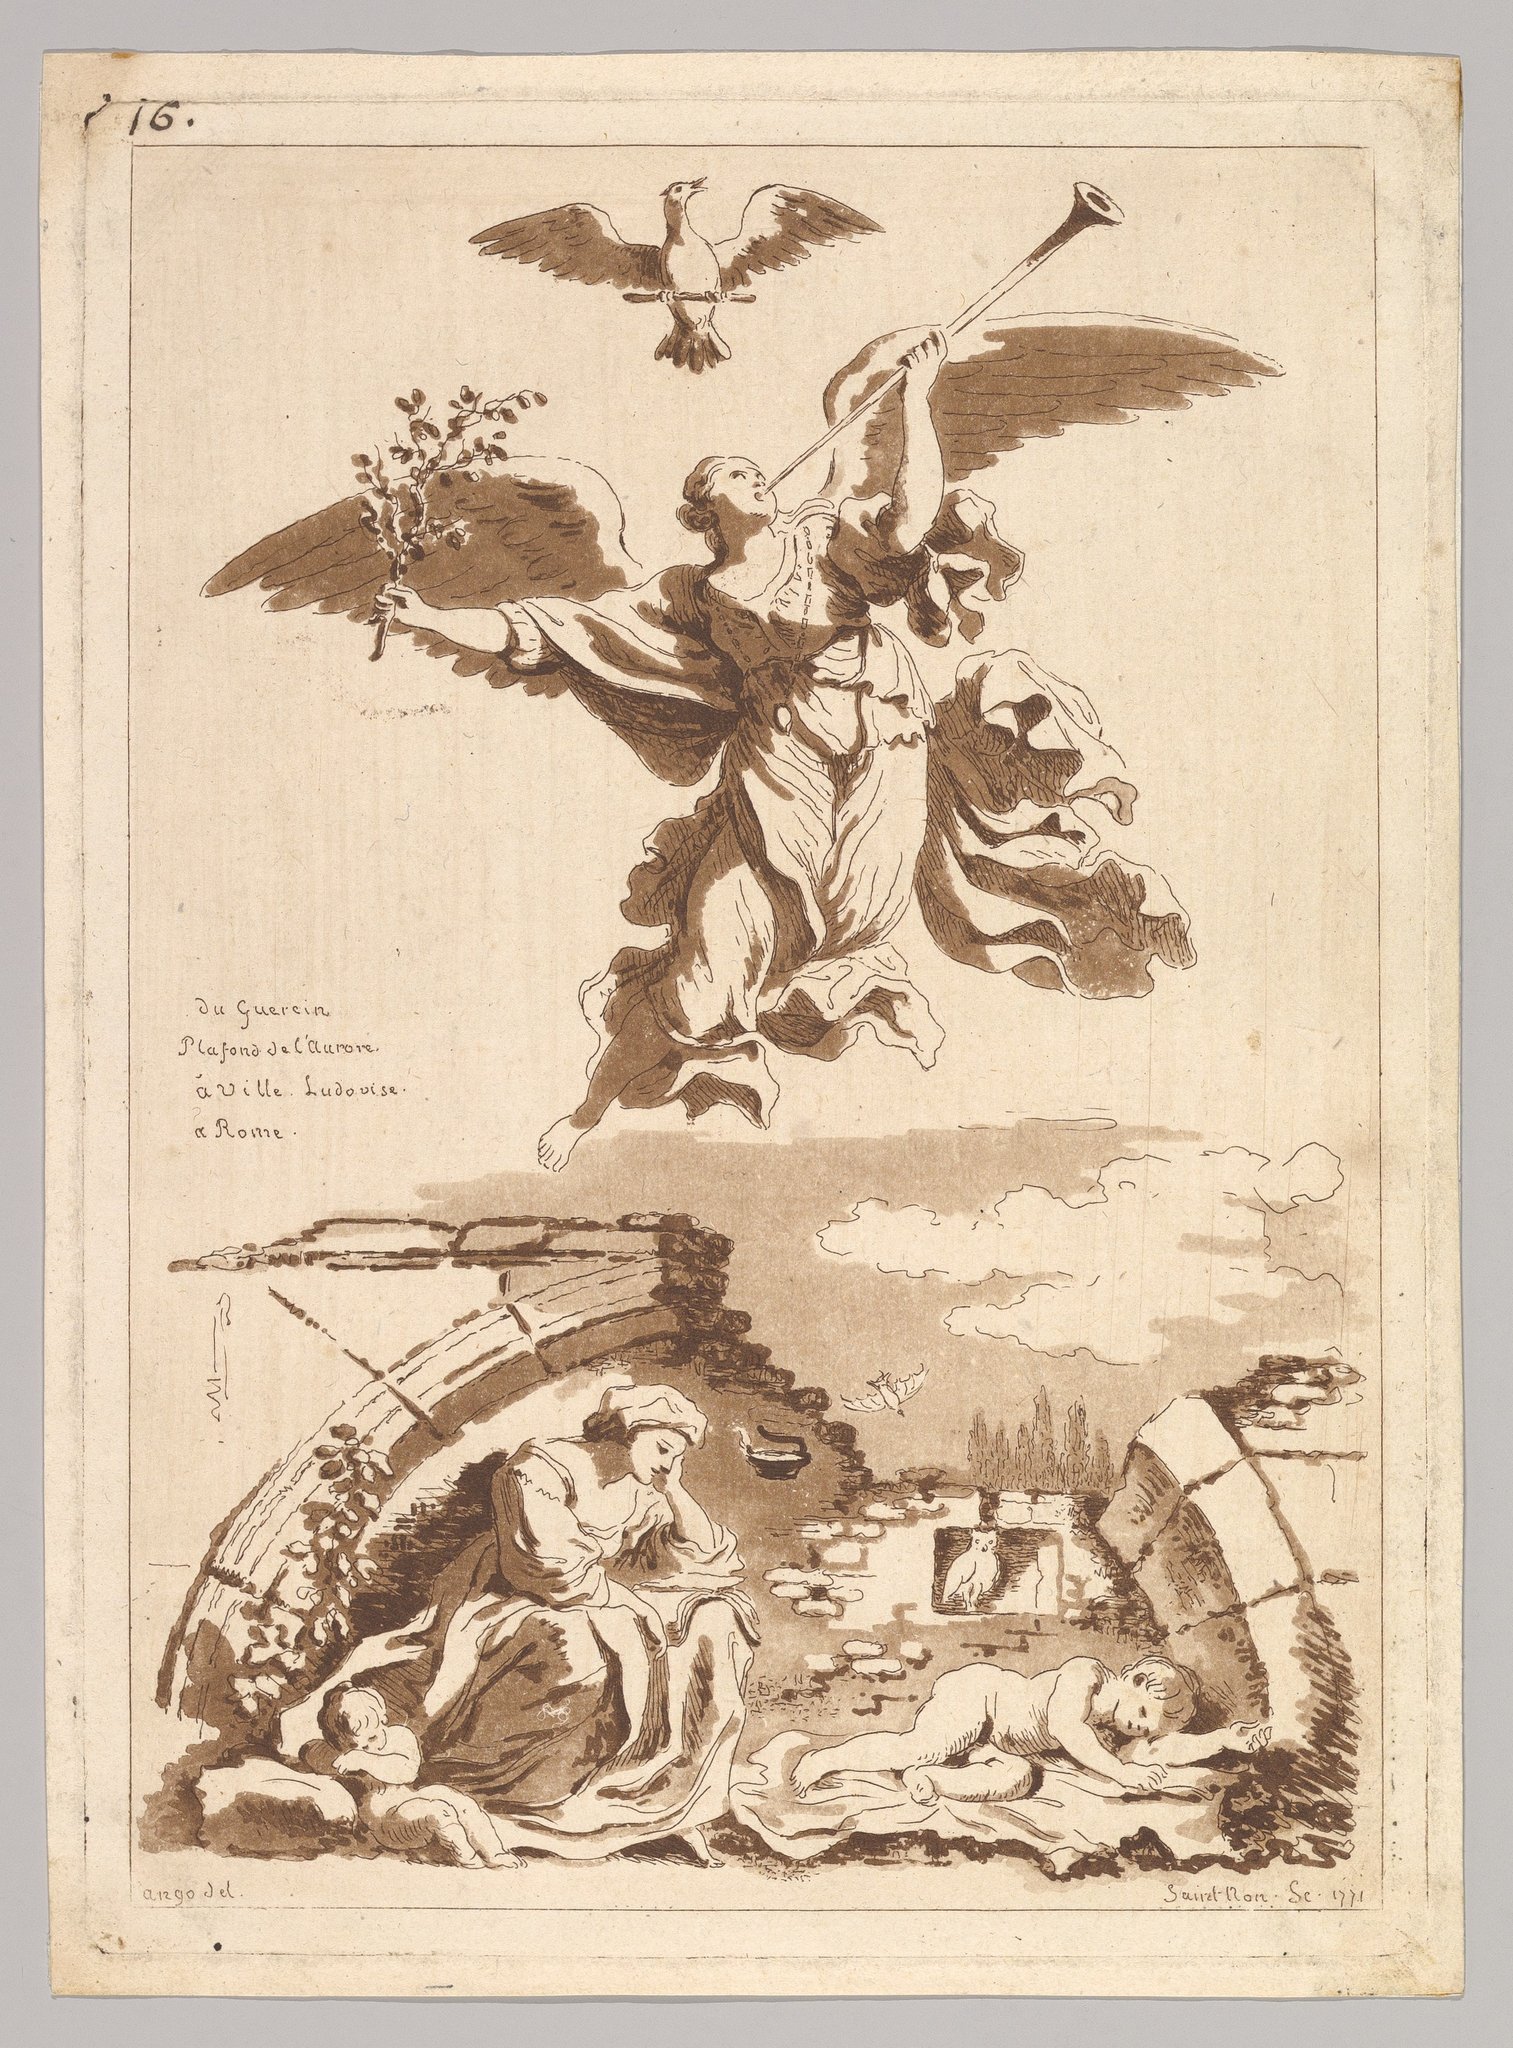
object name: print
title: Fragments choisis dans les Peintures et les Tableaux les plus interessants des Palais et des Eglises d'Italie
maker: jean claude richard, abbé de saint-non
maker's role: artist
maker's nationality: french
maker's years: 1727-1791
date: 1701-1800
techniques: etching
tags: musical instruments,sleeping,boys,women,angels